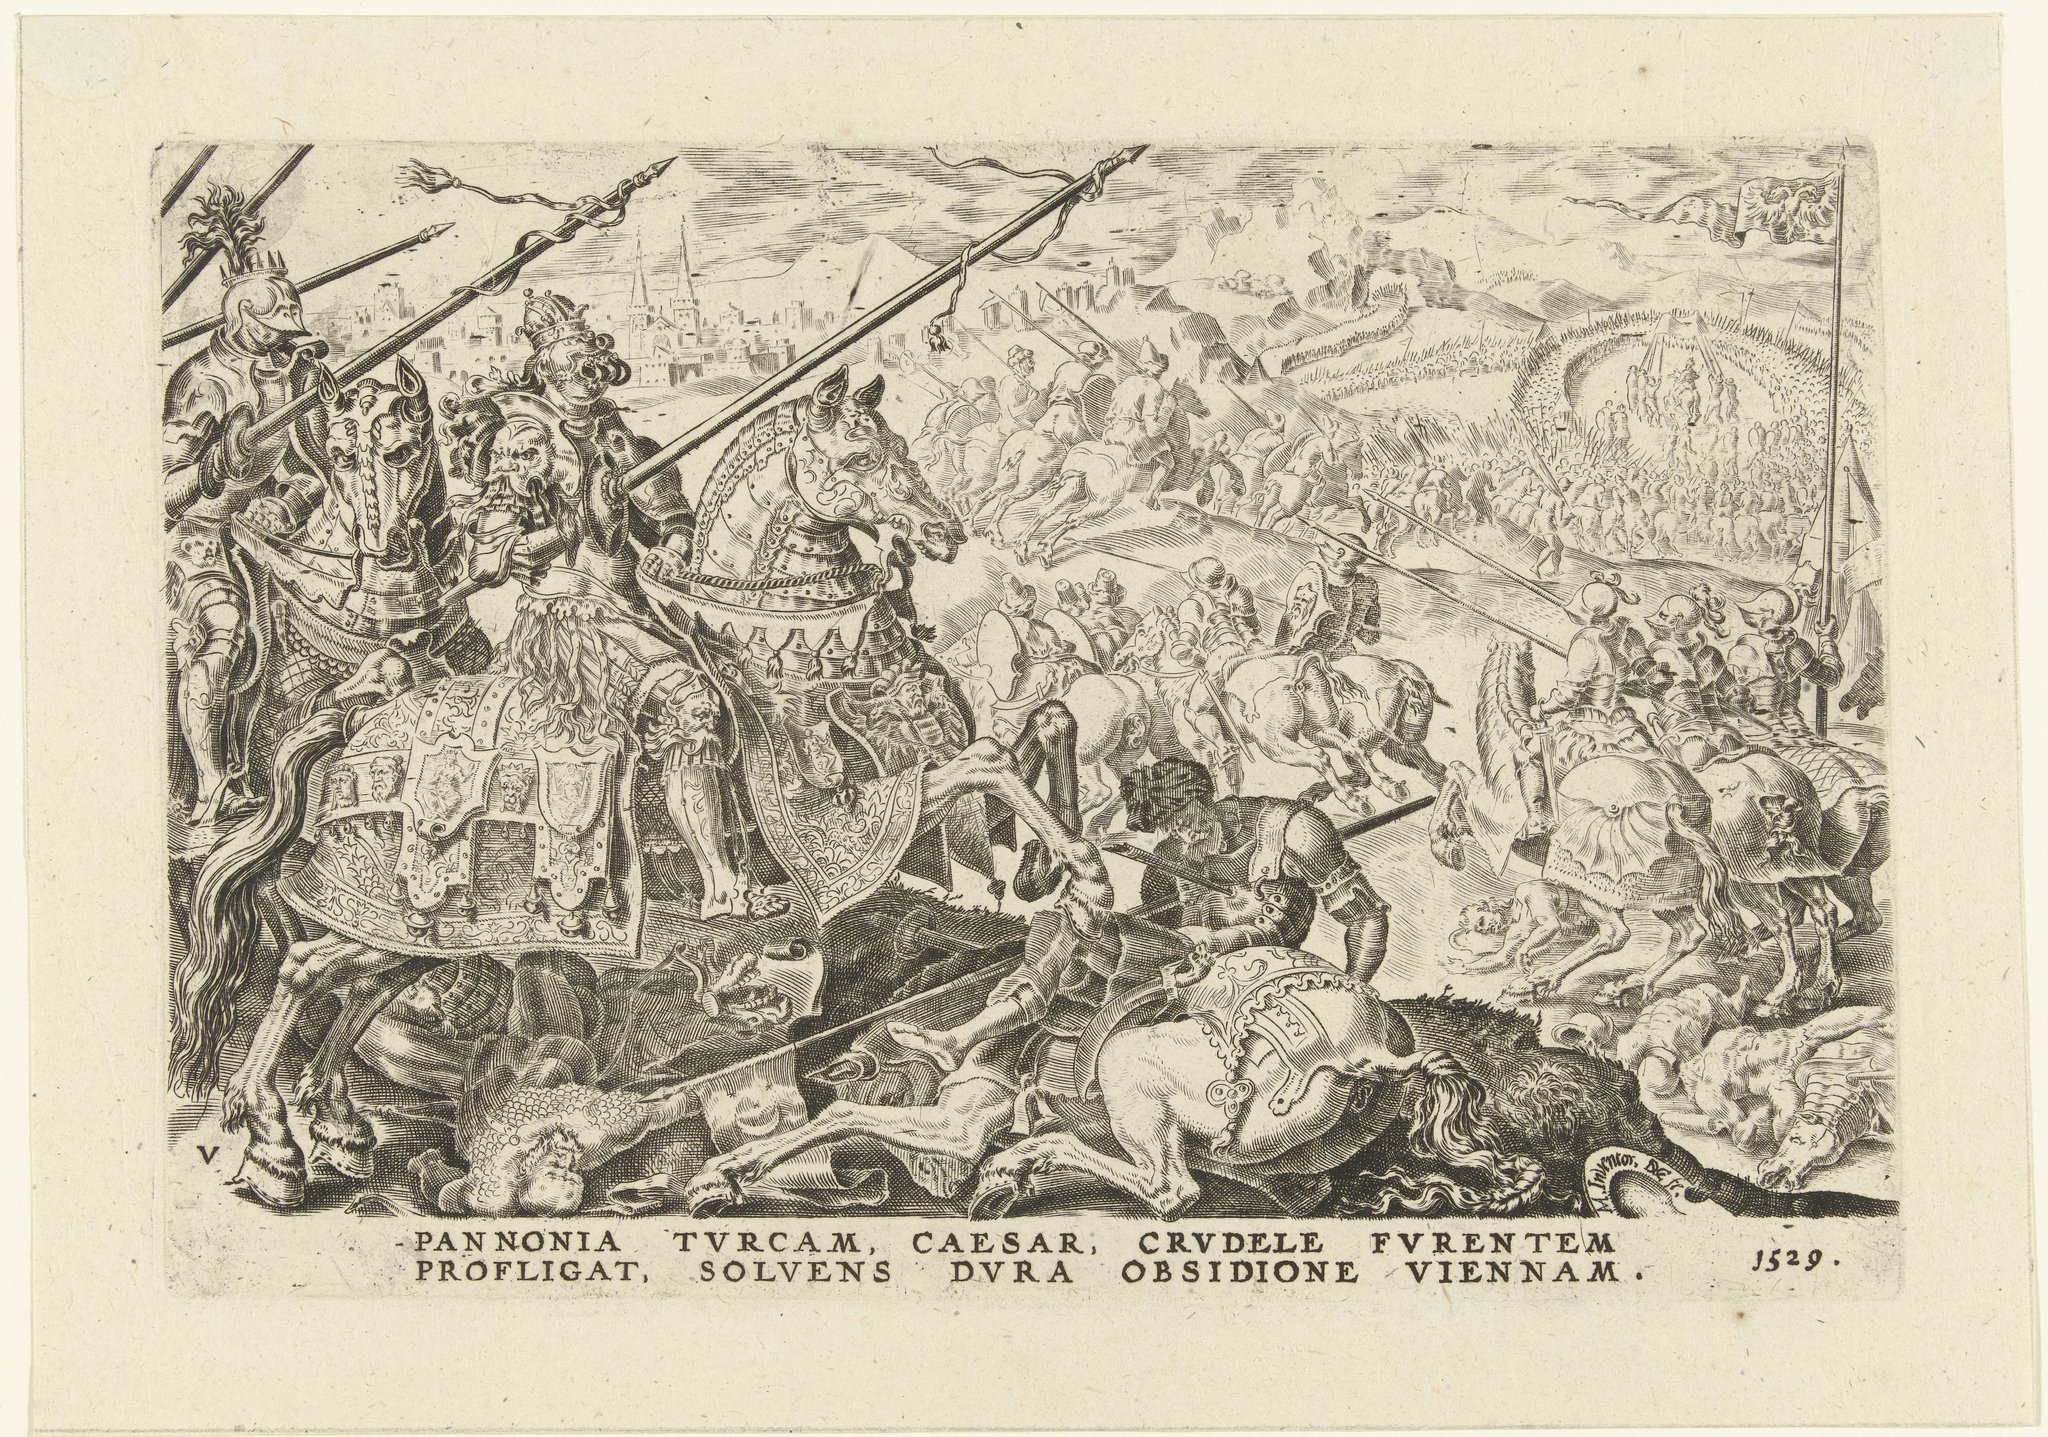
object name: propagandaprent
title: Divi Caroli. V. imp. opt. max. victoriae, ex multis praecipuae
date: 1555-1556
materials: paper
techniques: engraving, etching, letterpress printing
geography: haarlem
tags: ghent, charles v (holy roman emperor and king of spain), ferdinand i van habsburg (duits keizer), vienna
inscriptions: collector's mark: Lugt 2228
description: Ontzet van Wenen. De legers van Karel V dwingen de Turken onder leiding van sultan Süleyman I de Grote het beleg van Wenen op te geven, 1529. Ridders met pieken te paard. Onderschrift in twee regels Latijn.